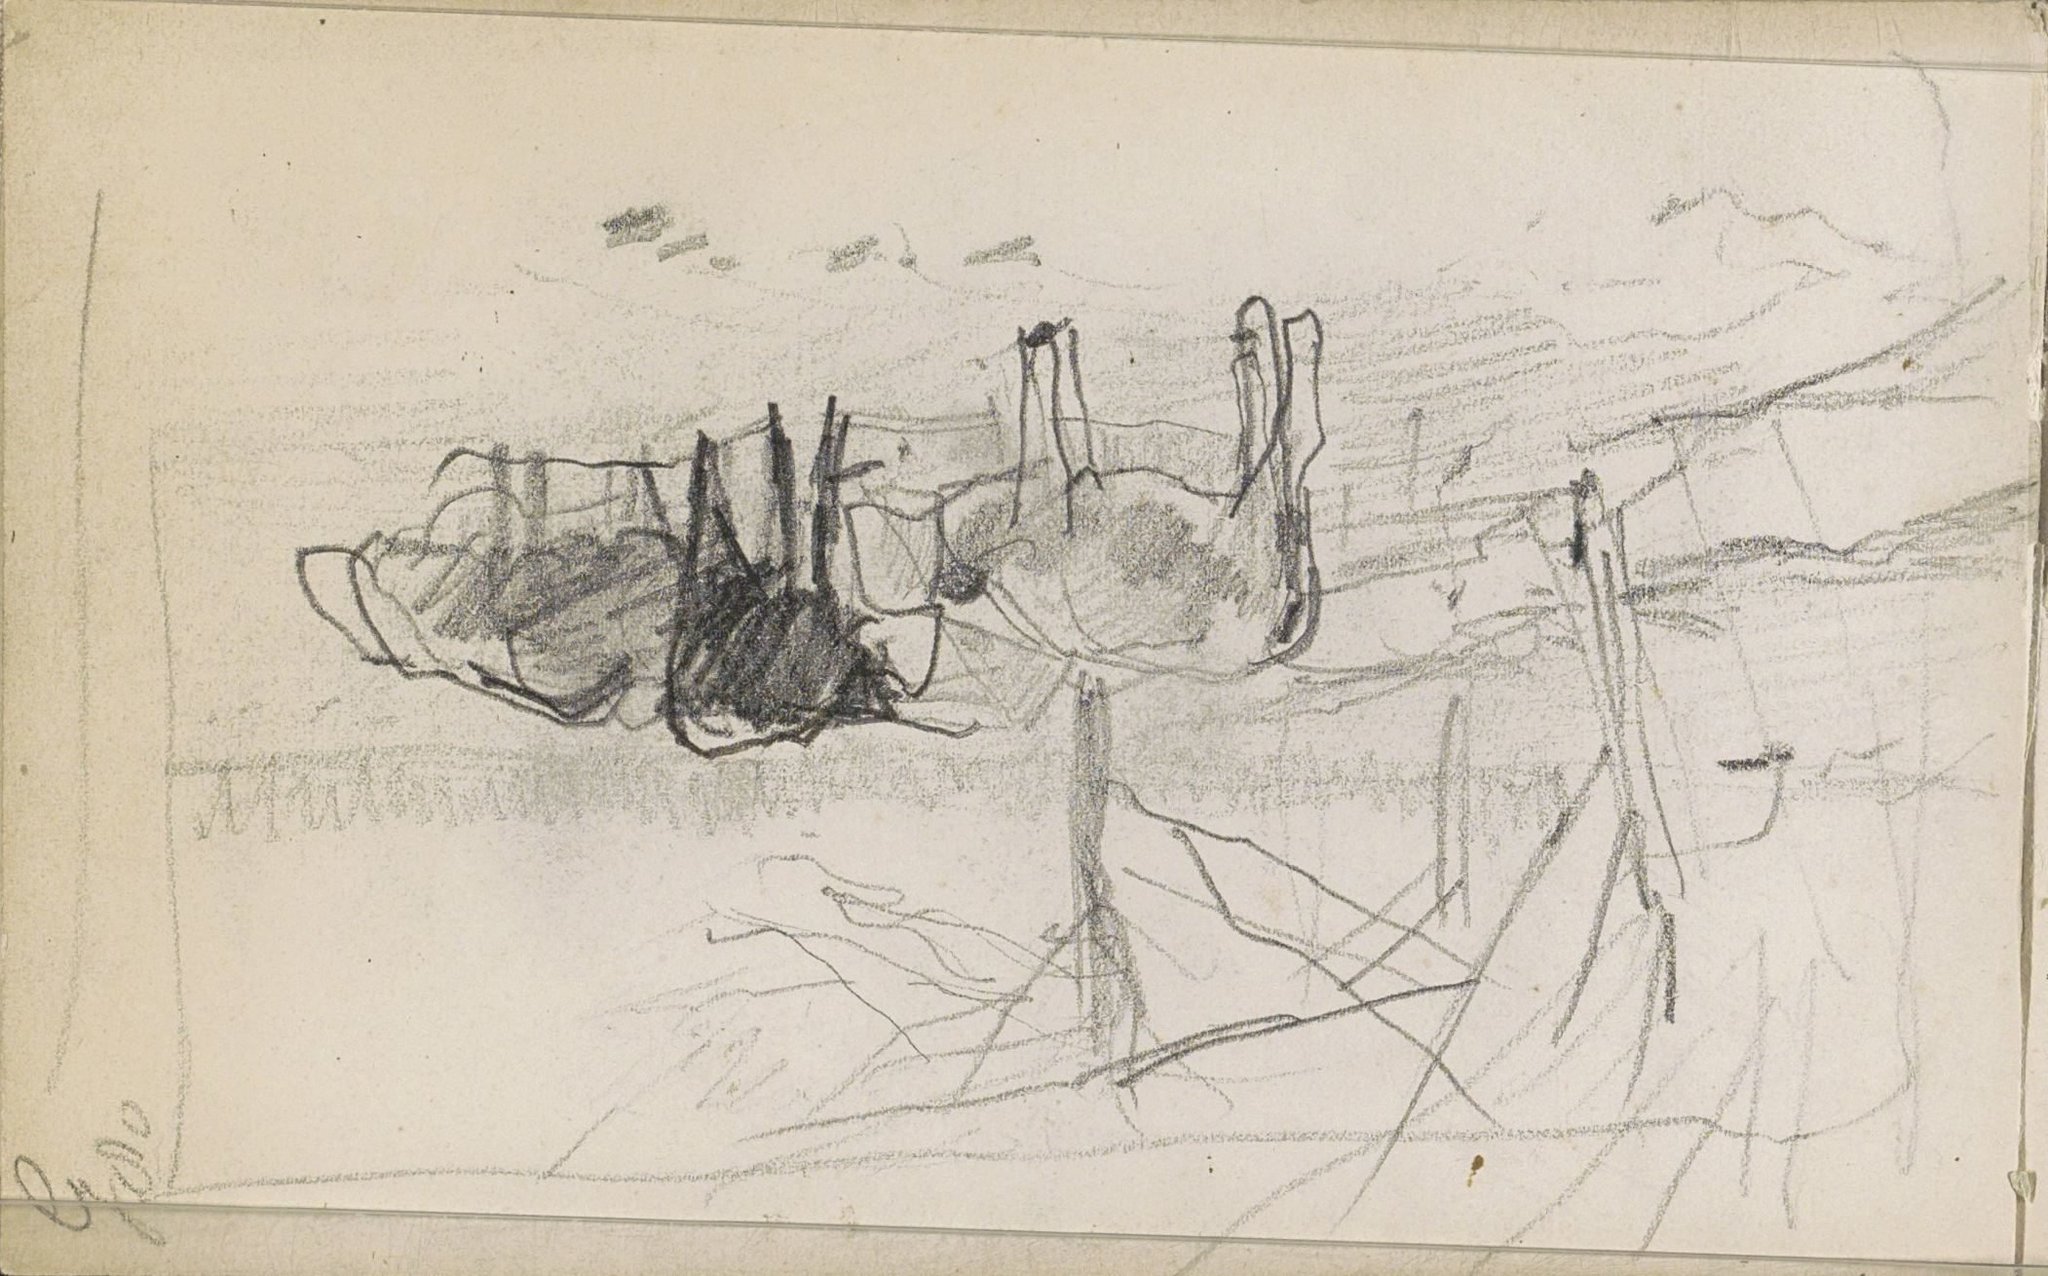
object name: sketchbook leaf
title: Weiland met koeien bij een sloot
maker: anton mauve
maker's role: draughtsman, painter, print maker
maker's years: 1838-1888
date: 1848-1888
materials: paper, pencil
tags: cow, meadow, pasture, small canal, ditch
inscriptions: annotation: ‘G80’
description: Blad 1 verso uit een schetsboek met 44 bladen.